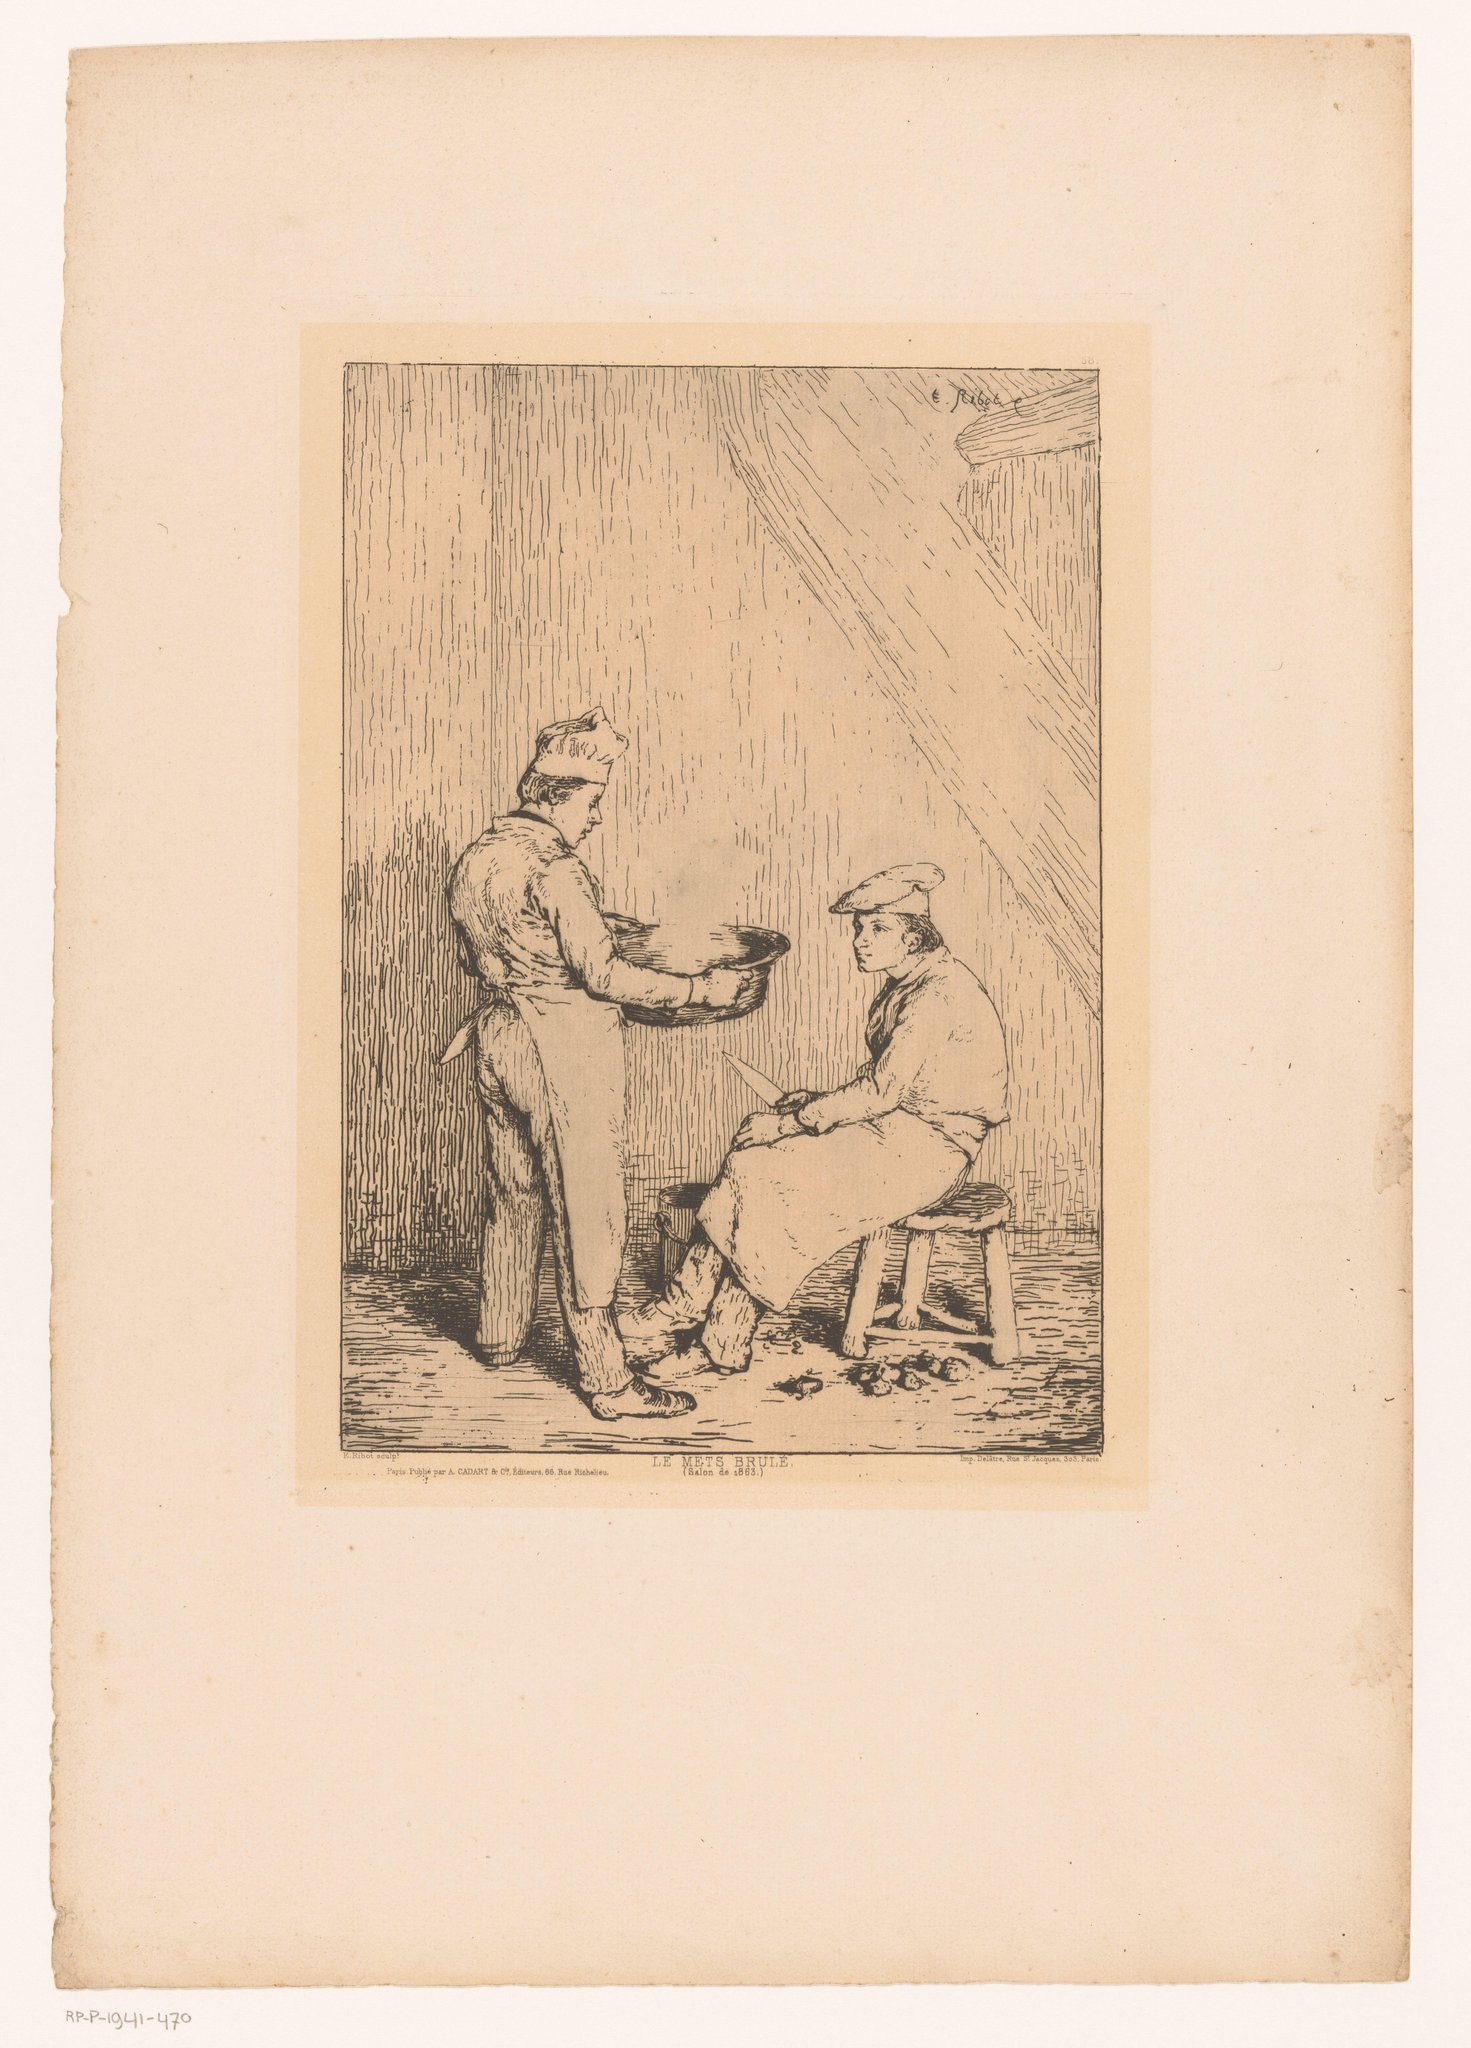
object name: print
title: Staande kok met pan en zittende kok met mes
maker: théodule augustin ribot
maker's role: draughtsman, painter, print maker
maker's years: 1823-1891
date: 1862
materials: paper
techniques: drypoint, etching, intaglio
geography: paris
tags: cook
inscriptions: collector's mark: Lugt 2760, collector's mark: Lugt 2228, collector's mark: Lugt 3270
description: Maakt deel uit van het eerste volume van een serie prenten door de Société des Aquafortistes uit 1862. Plaat 58.